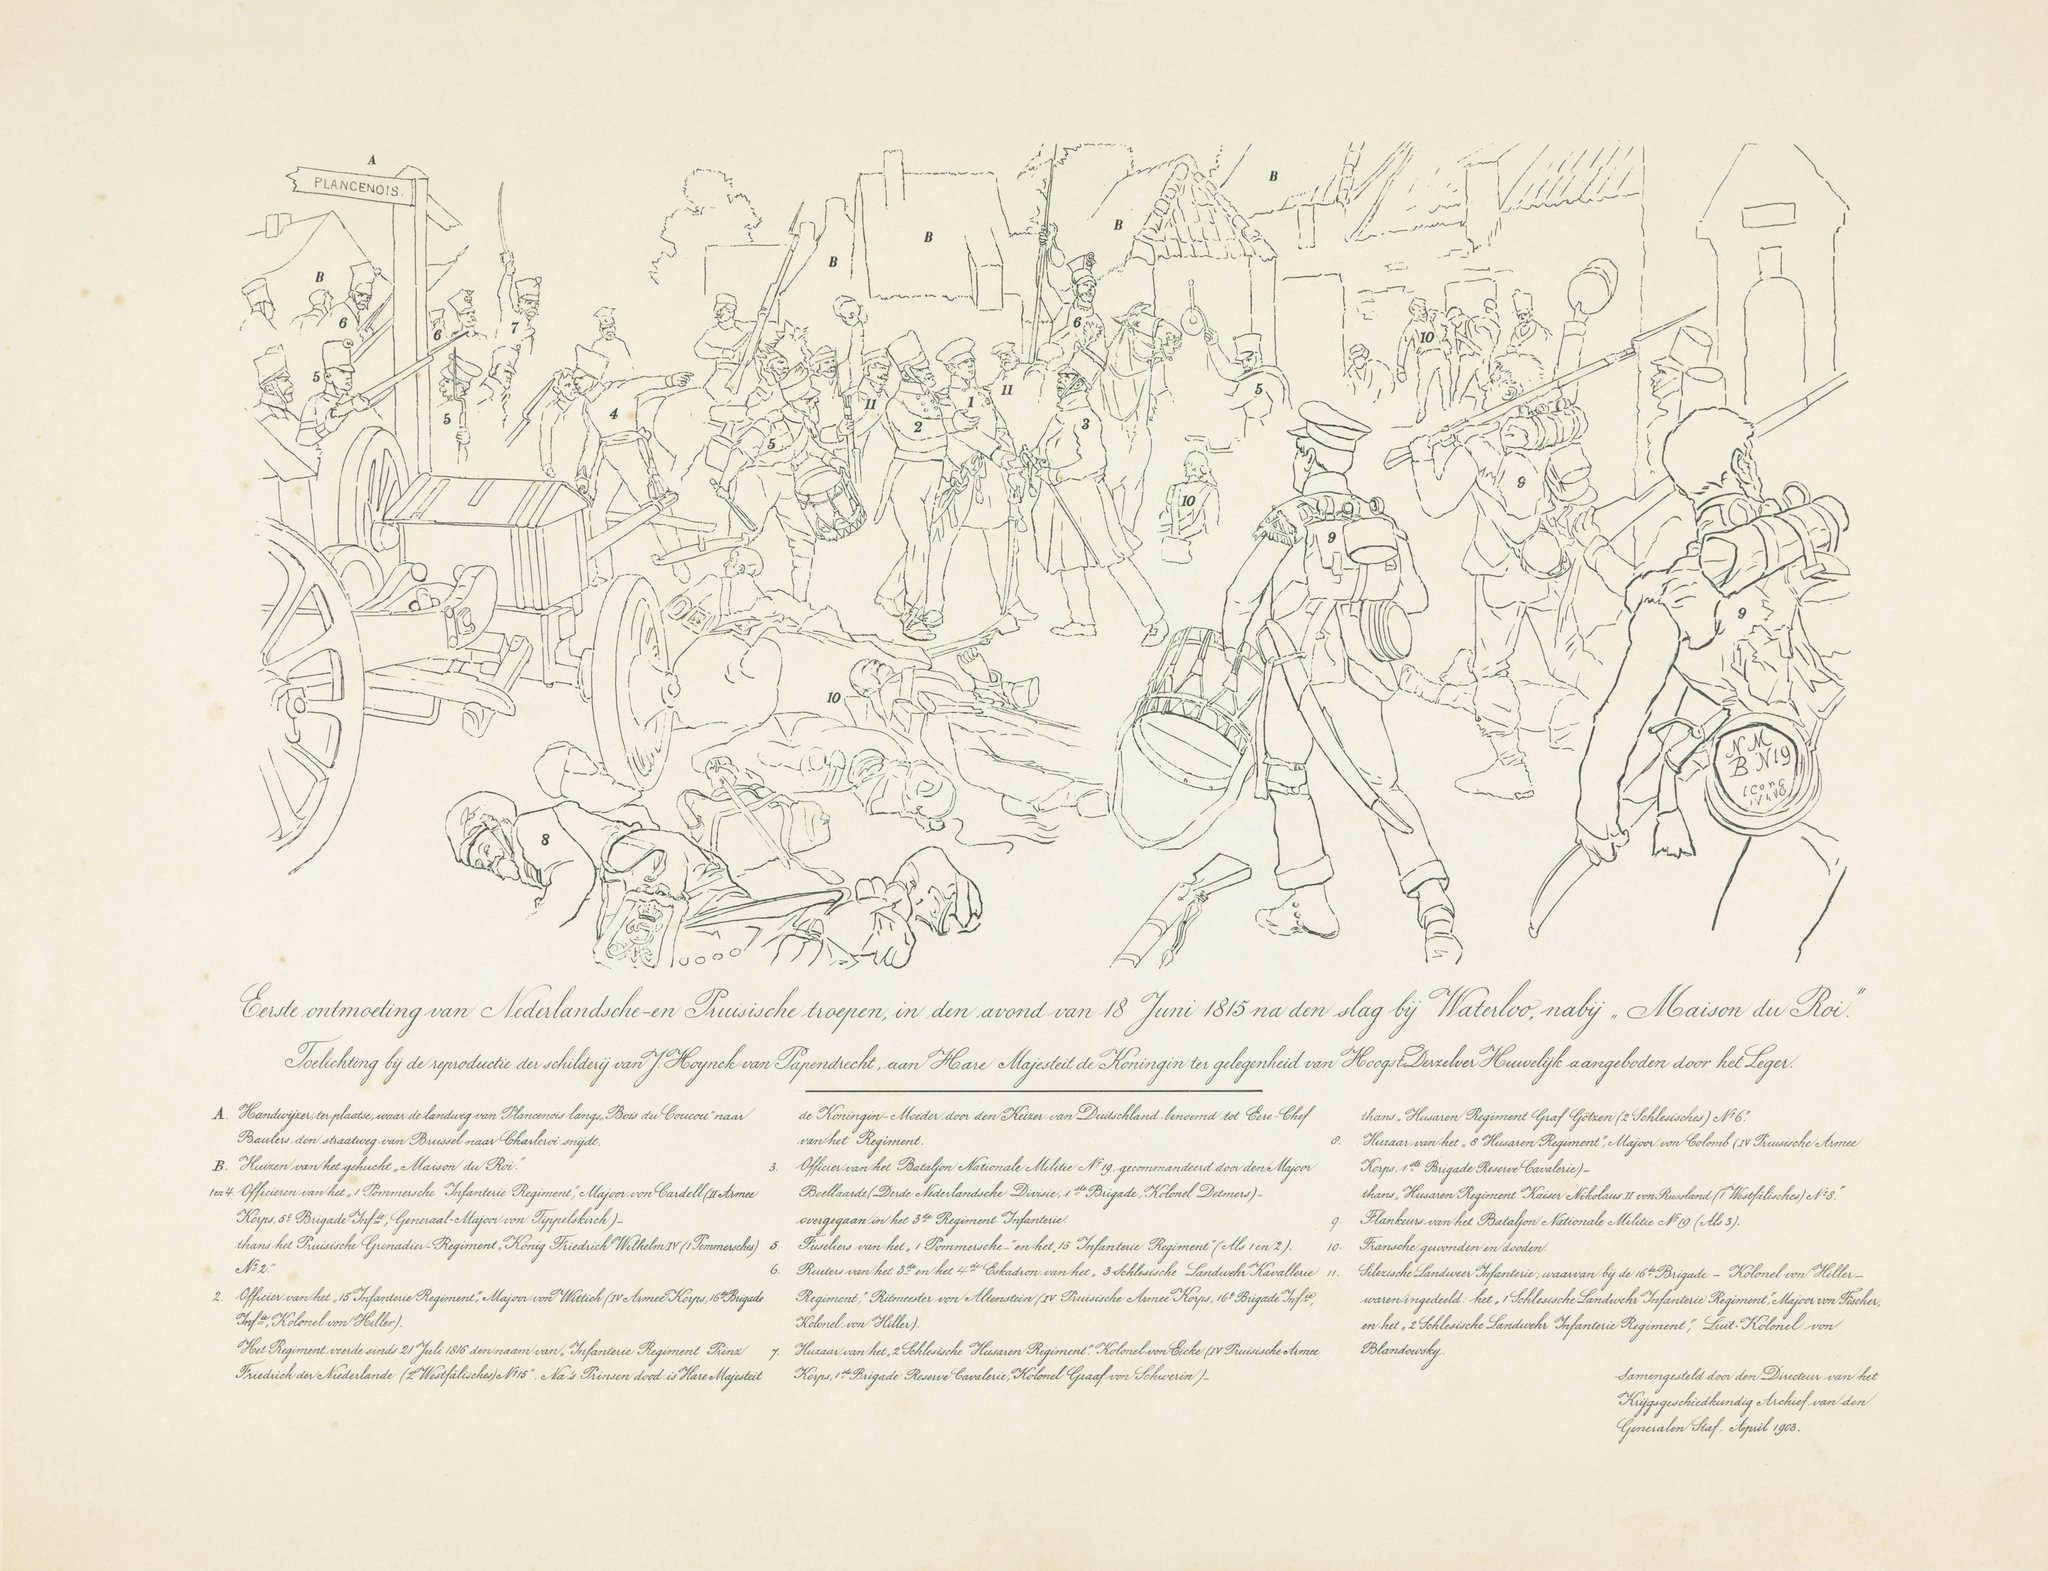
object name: reproduction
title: Eerste ontmoeting van Nederlandsche - en Pruisische troepen, in den avond van 18 Juni 1815 na den slag bij Waterloo, nabij "Maison du Roi". Toelichting bij de reproductie der schilderij van J. Hoynck van Papendrecht, aan Hare Majesteit de Koningin ter gelegenheid van Hoogst Derzelver Huwelijk aangeboden door het Leger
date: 1903-1904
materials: paper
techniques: photograph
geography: netherlands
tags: victor (after the battle), waterloo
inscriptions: collector's mark: Lugt 2228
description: Sleutel behorend bij een reproductie van het schilderij van Hoynck van Papendrecht voorstellende de ontmoeting van Nederlandse en Pruisische troepen na de slag bij Waterloo, in het gehoucht 'Maison du Roi', op 18 juni 1815. Rechts de Nederlandse militairen van Bataljon 19 van de Nationale Militie. De twee legers treffen elkaar in tussen de huizen van het dorp. De belangrijkste elementen in het schilderij in contouren afgebeeld en genummerd. Met legenda A-B en 1-11. Zie de bijbehorende prent.